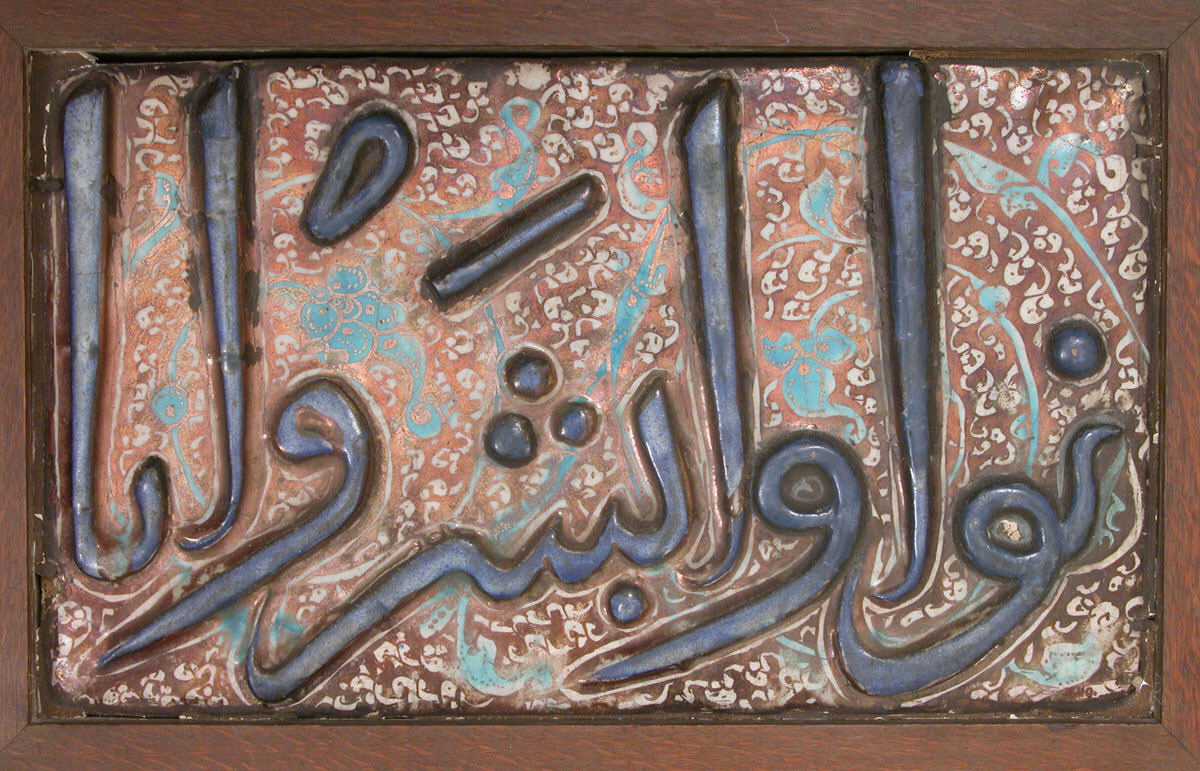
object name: tile from a frieze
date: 1201-1300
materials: stonepaste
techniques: luster painting, molding, overglaze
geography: iran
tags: arabic,calligraphy